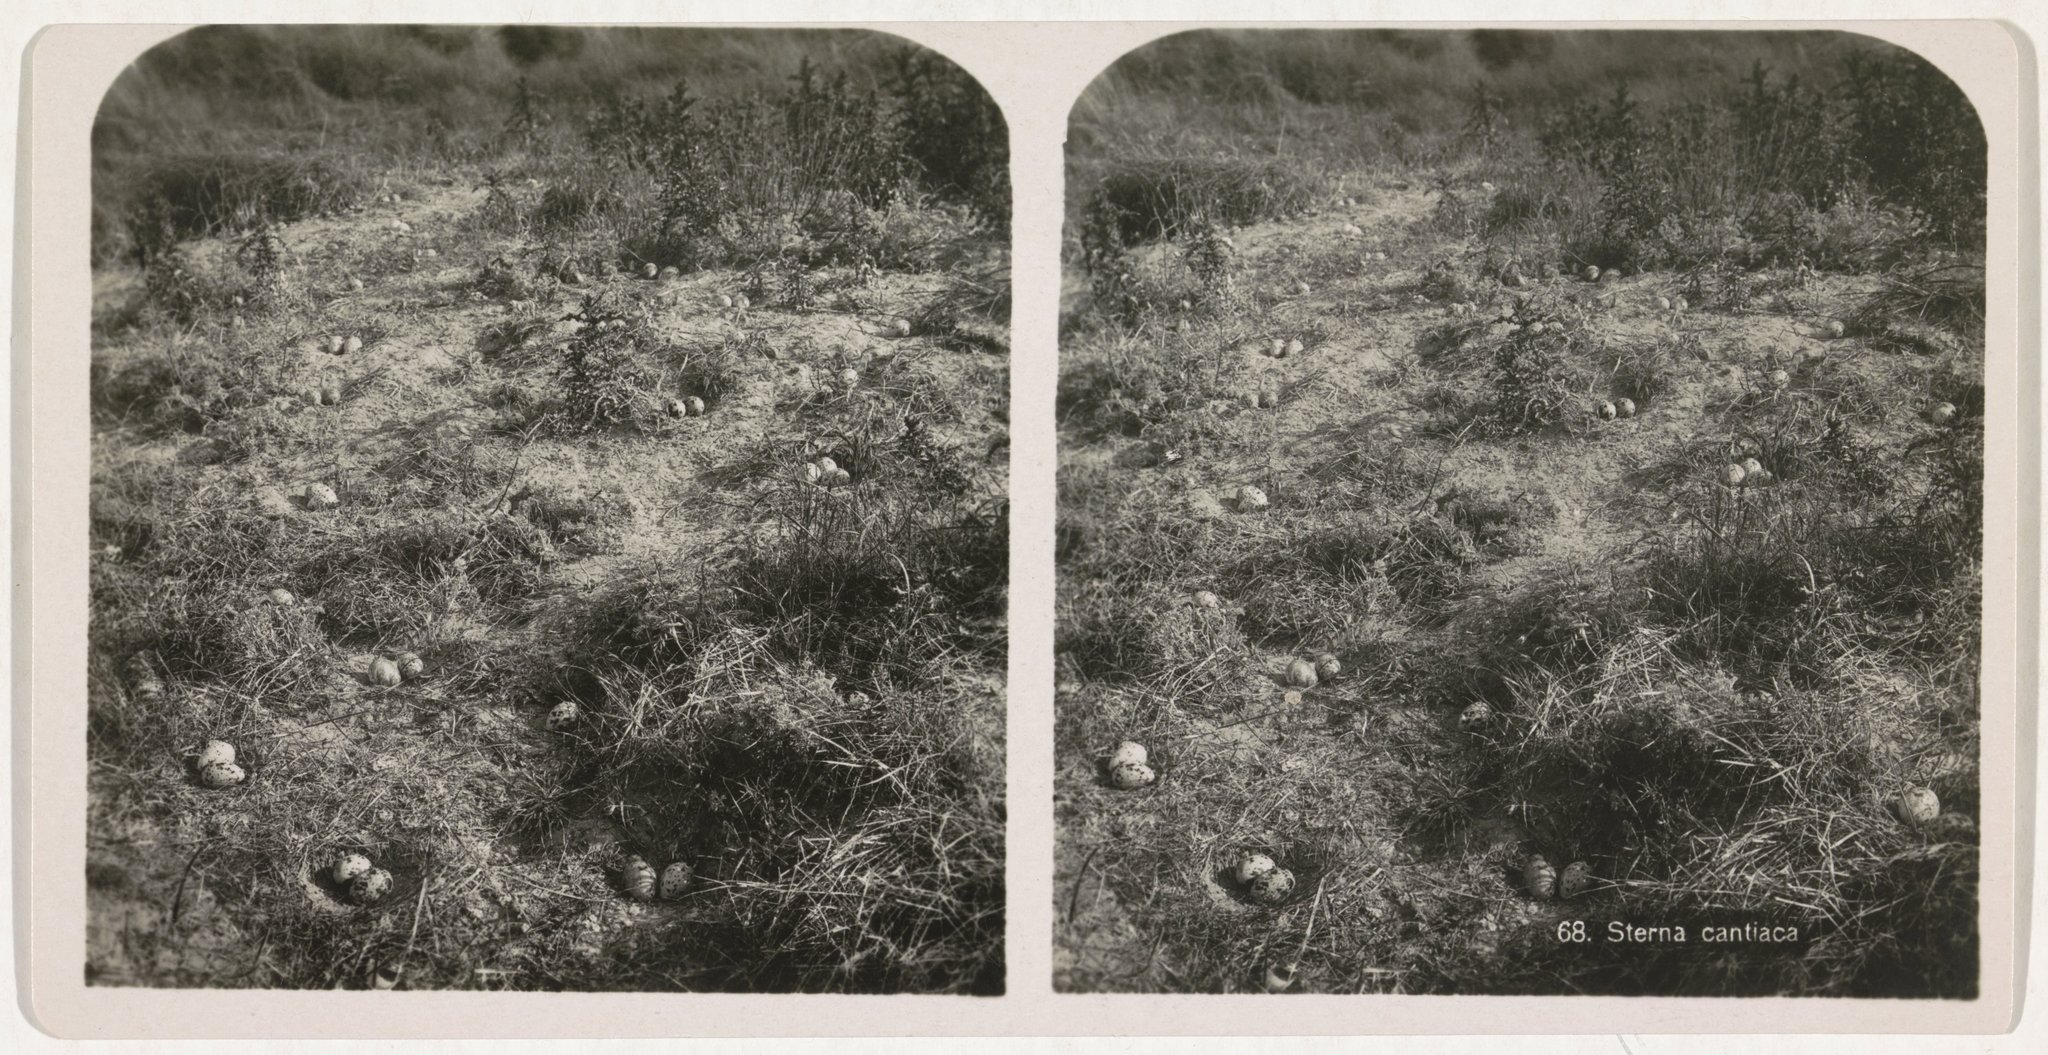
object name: photograph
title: 68. Sterna cantiaca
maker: adolphe burdet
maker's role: fotograaf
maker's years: 1860-1940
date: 1870-1940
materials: photographic support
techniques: gelatin silver print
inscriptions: label: ‘Eieren van de Zee Zwaluwen’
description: De foto maakt deel uit van een serie van 12 stereofoto's, bewaard in het originele mapje. De foto's tonen zeevogels in natuurgebied De Bol op Texel.